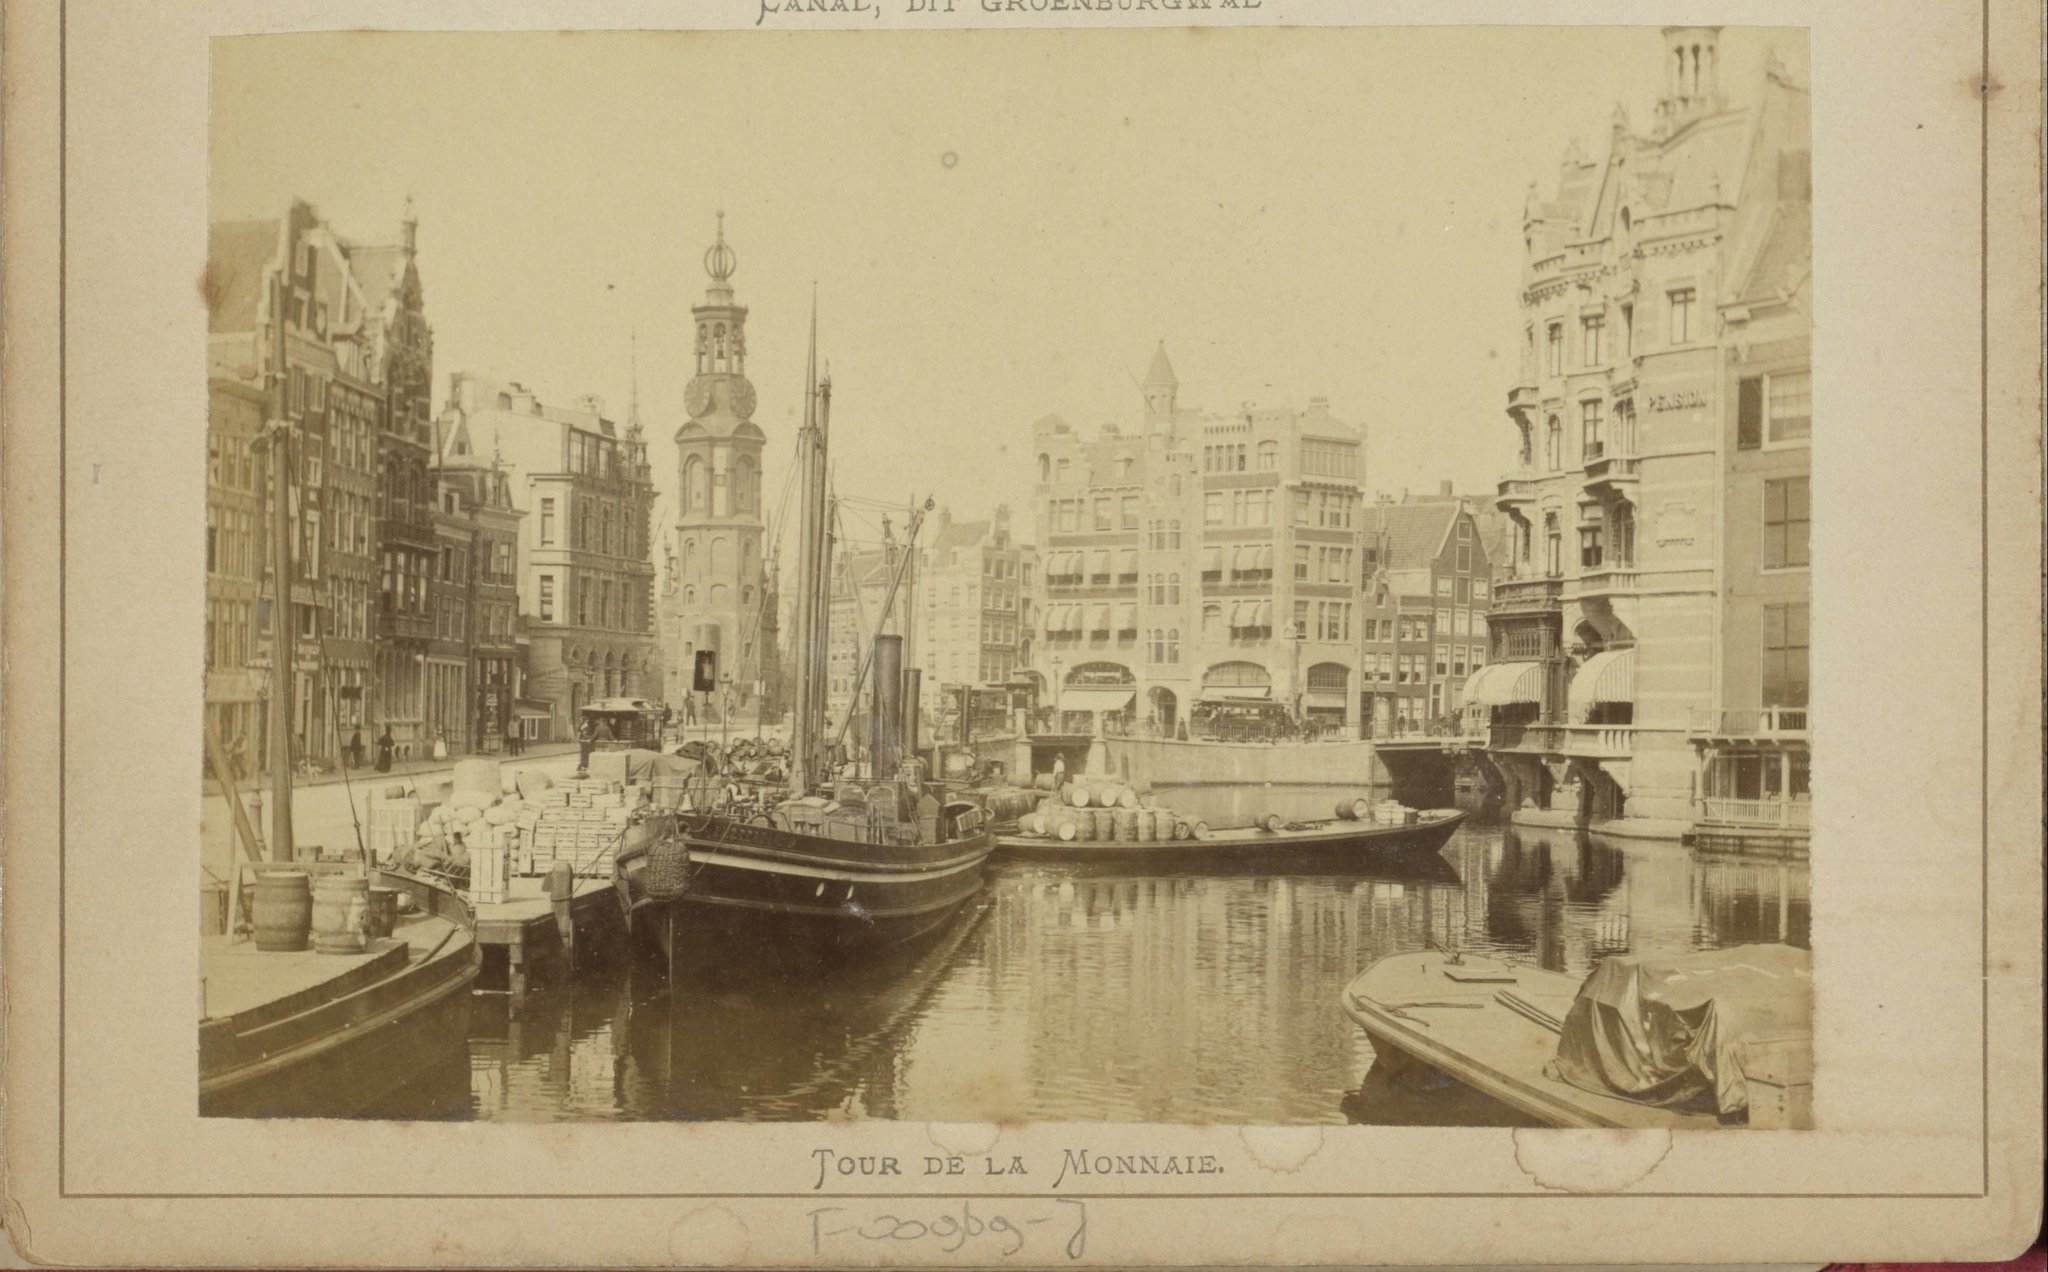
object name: photograph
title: Gezicht op het Sophiaplein (Muntplein) in Amsterdam met links de Munttoren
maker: andries jager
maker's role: publisher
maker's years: 1825-1905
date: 1875-1910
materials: cardboard, paper, photographic support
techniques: albumen print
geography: amsterdam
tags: towers ~ fortified city, canal, ships (in general)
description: Onderdeel van Leporelloalbum met 28 foto's van Amsterdam en omstreken.